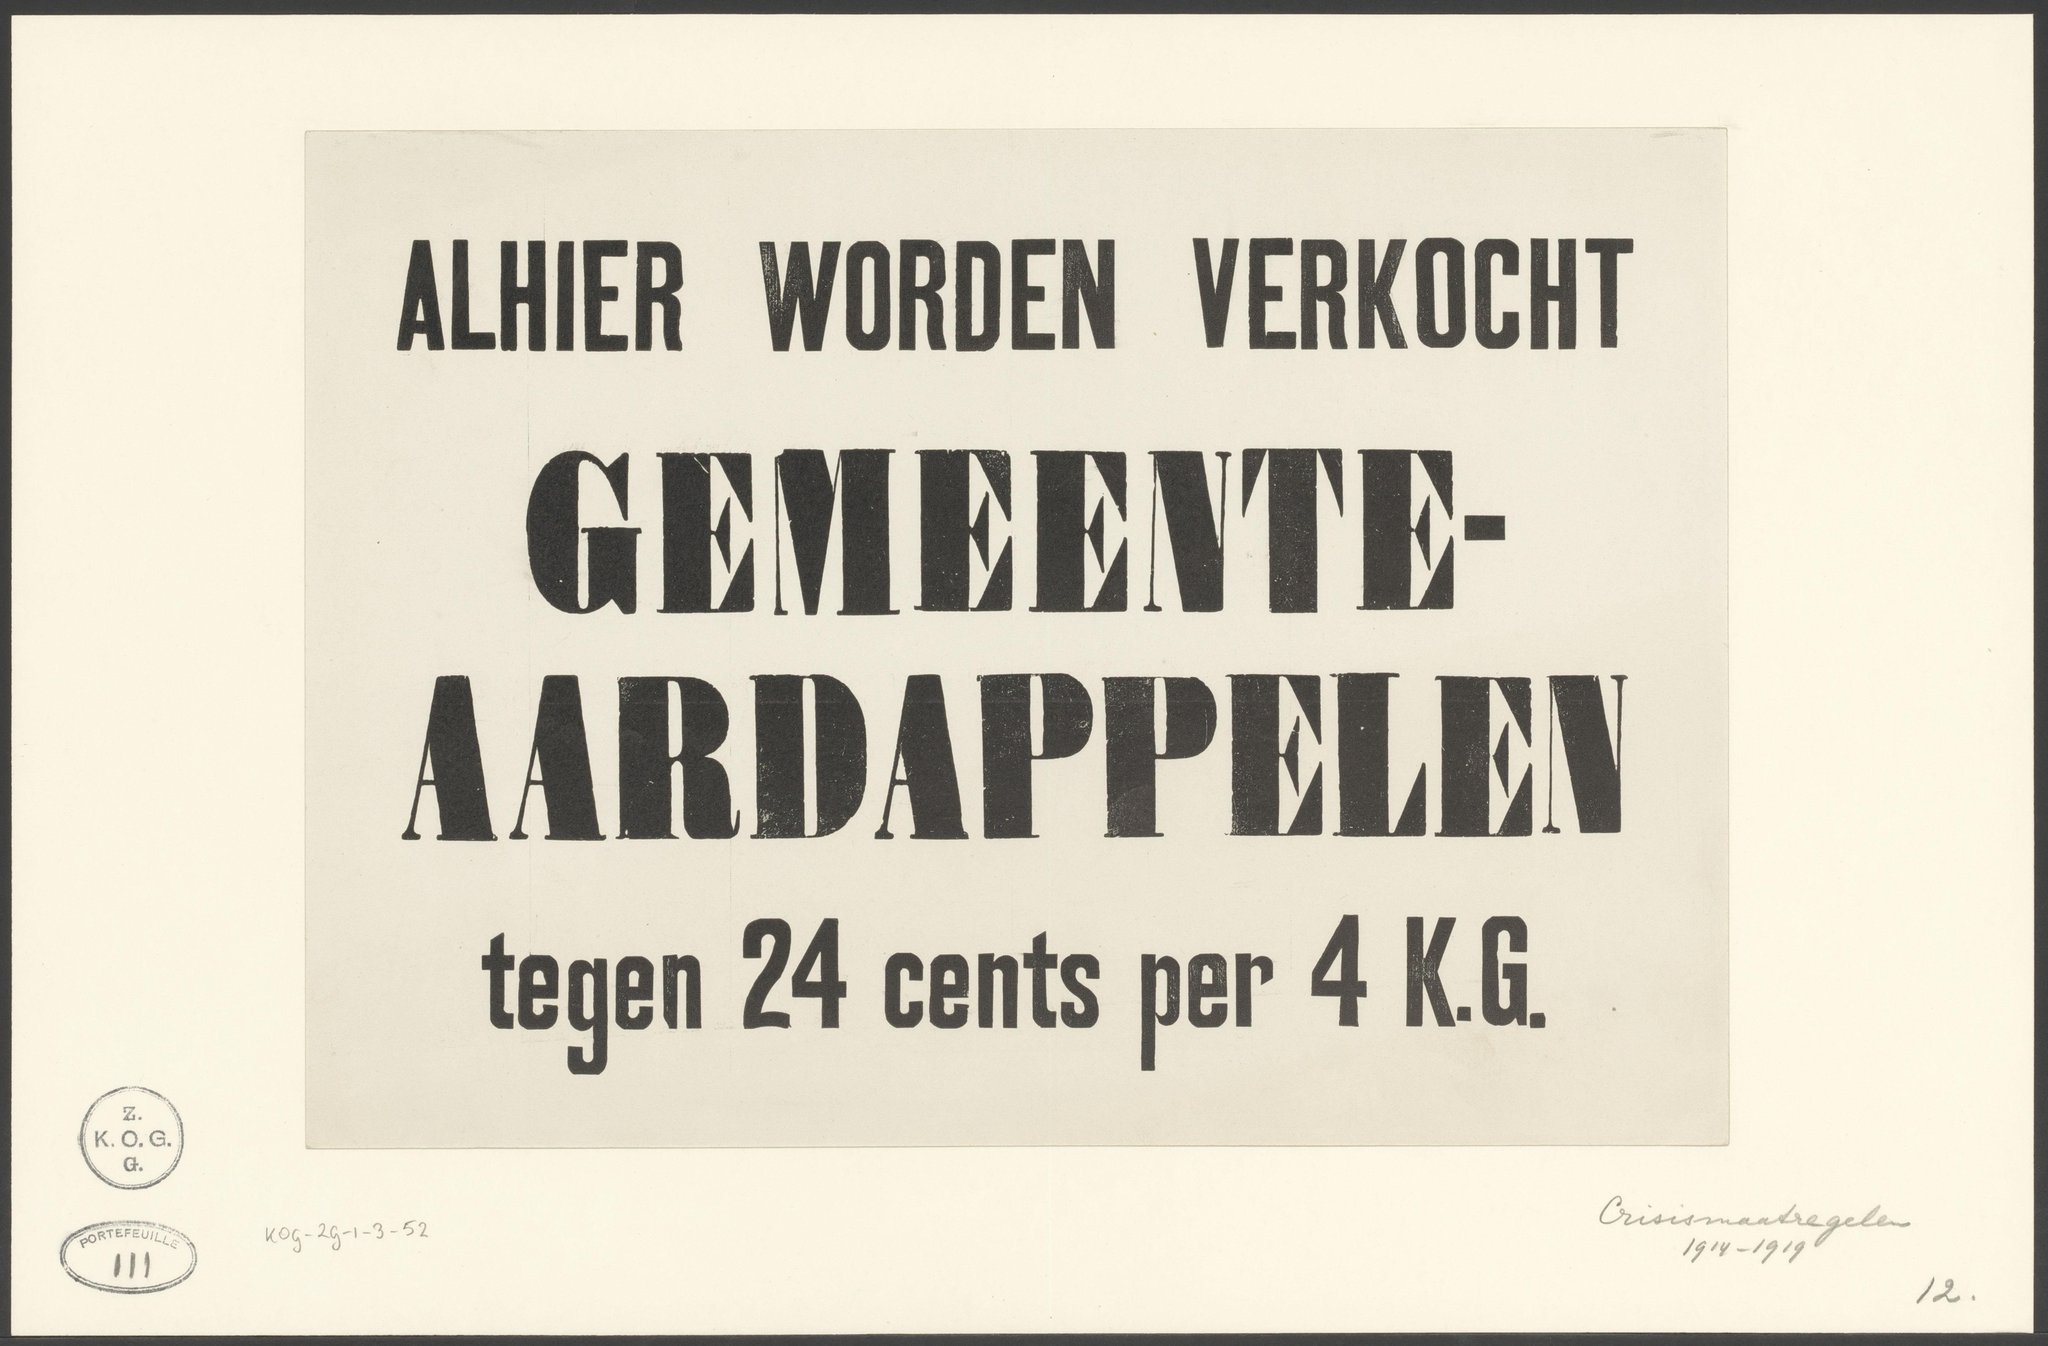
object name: document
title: Gemeente-aardappelen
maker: Anonymous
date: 1914-1918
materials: paper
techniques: letterpress printing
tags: potatoes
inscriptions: stamp, collector's mark: Lugt 1641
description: Aankondiging voor gemeente aardappels van 24 cent per 4 kilo. Tijdens de crisisjaren in de Eerste Wereldoorlog hield de regering de prijzen van bepaalde voedingsmiddelen kunstmatig laag. Onderwerpsrubrieken binnen de Atlas Zeden en Gewoonten: Regeering, Crisismaatregelen gedurende den wereldoorlog 1914-1919.